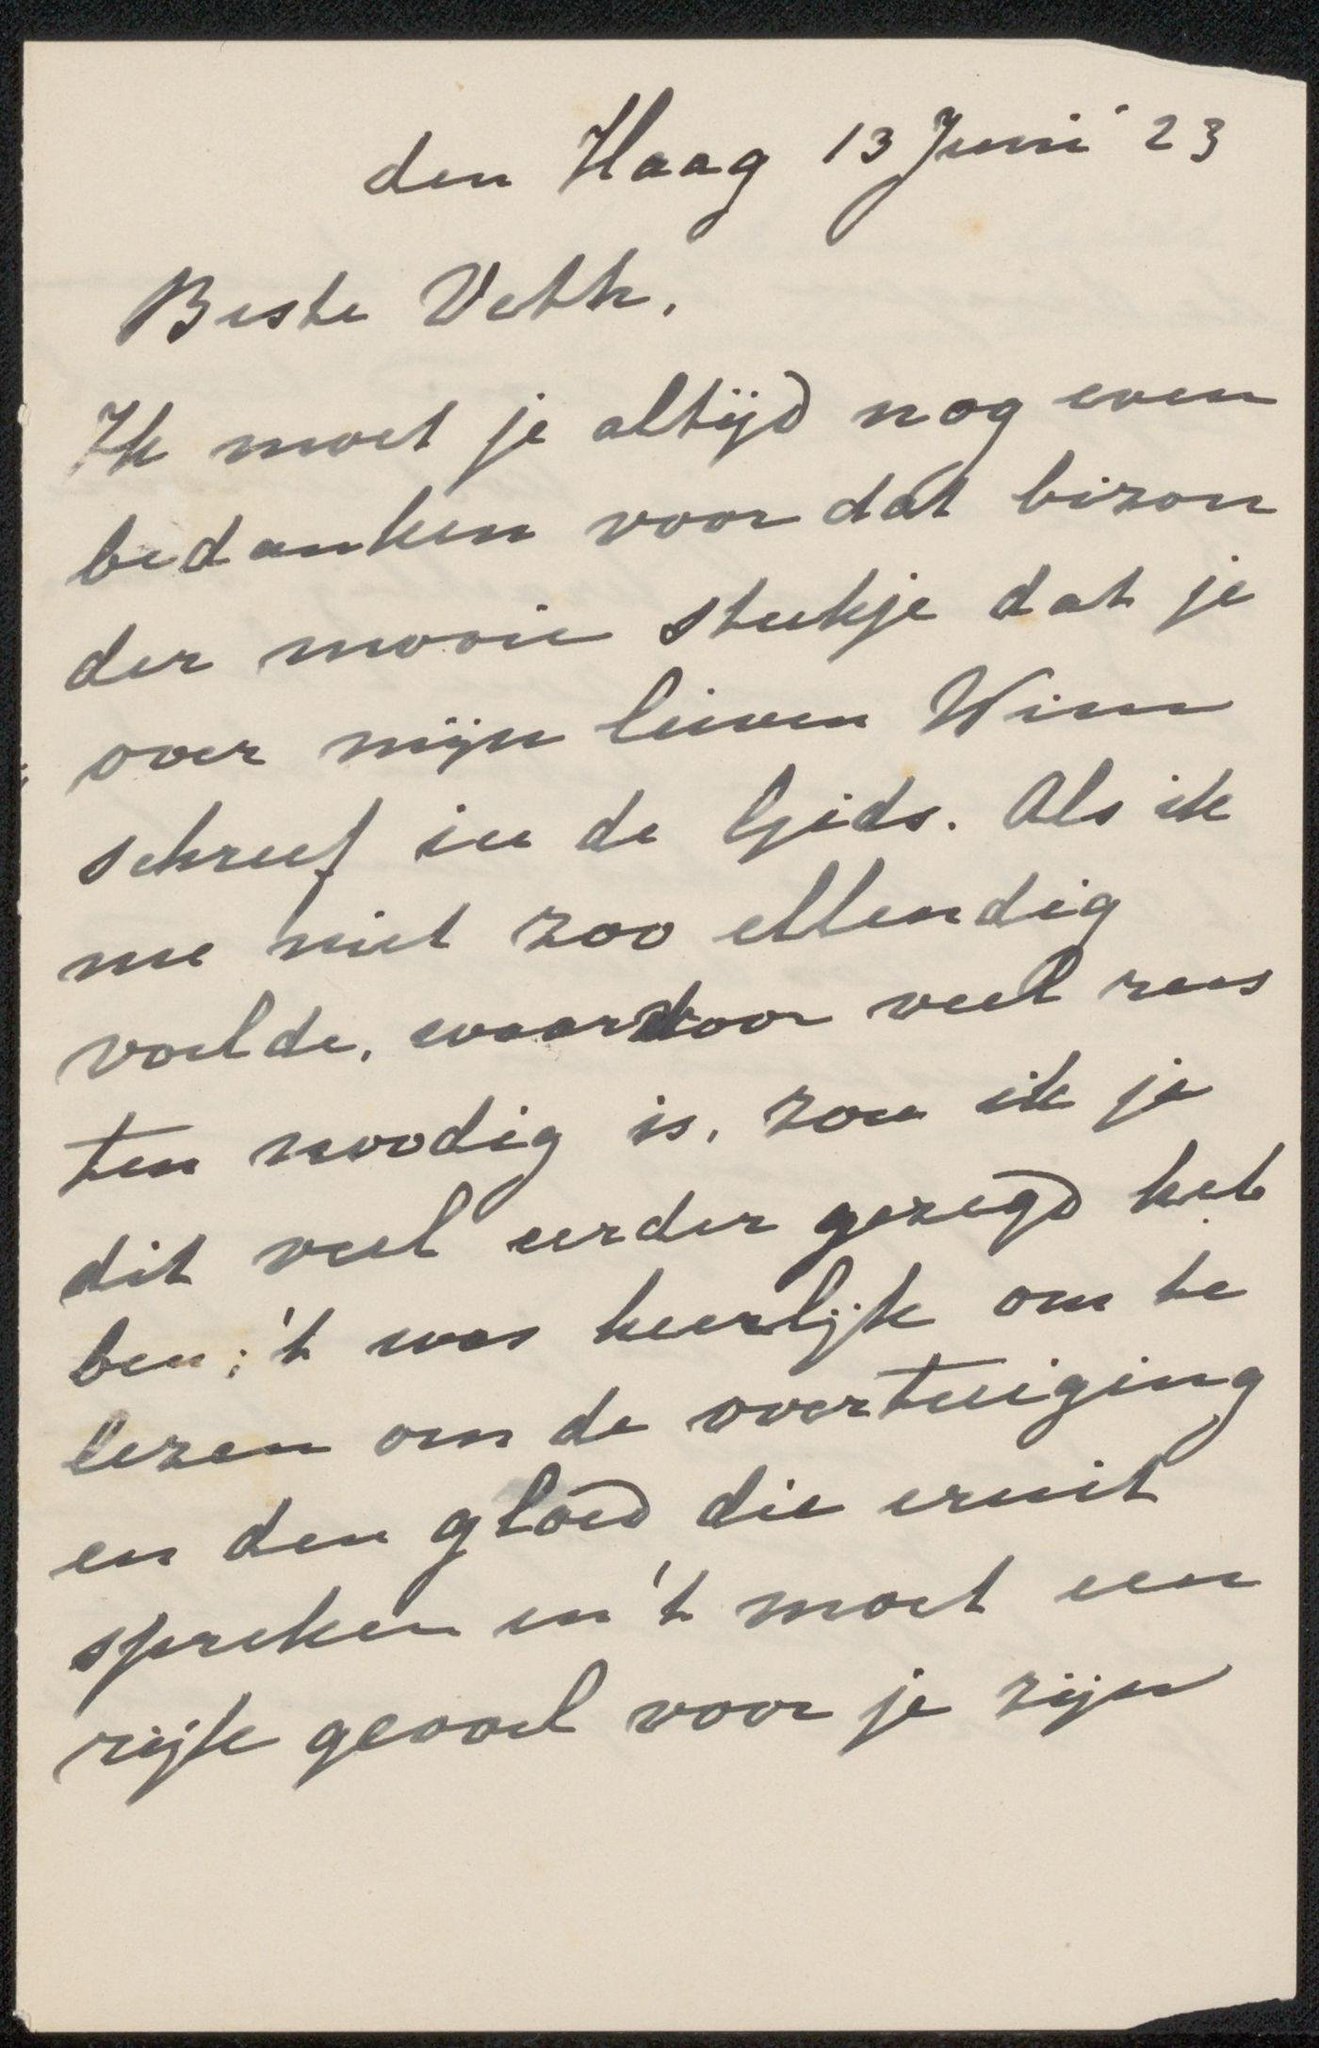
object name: letter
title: Brief aan Jan Veth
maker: coby witsen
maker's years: 1851-1930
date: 1923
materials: ink, paper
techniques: pen, writing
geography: the hague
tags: dordrecht, designer, jan veth, amsterdam, painter, print maker, draughtsman, willem witsen, diseases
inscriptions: collector's mark: ‘RPK’